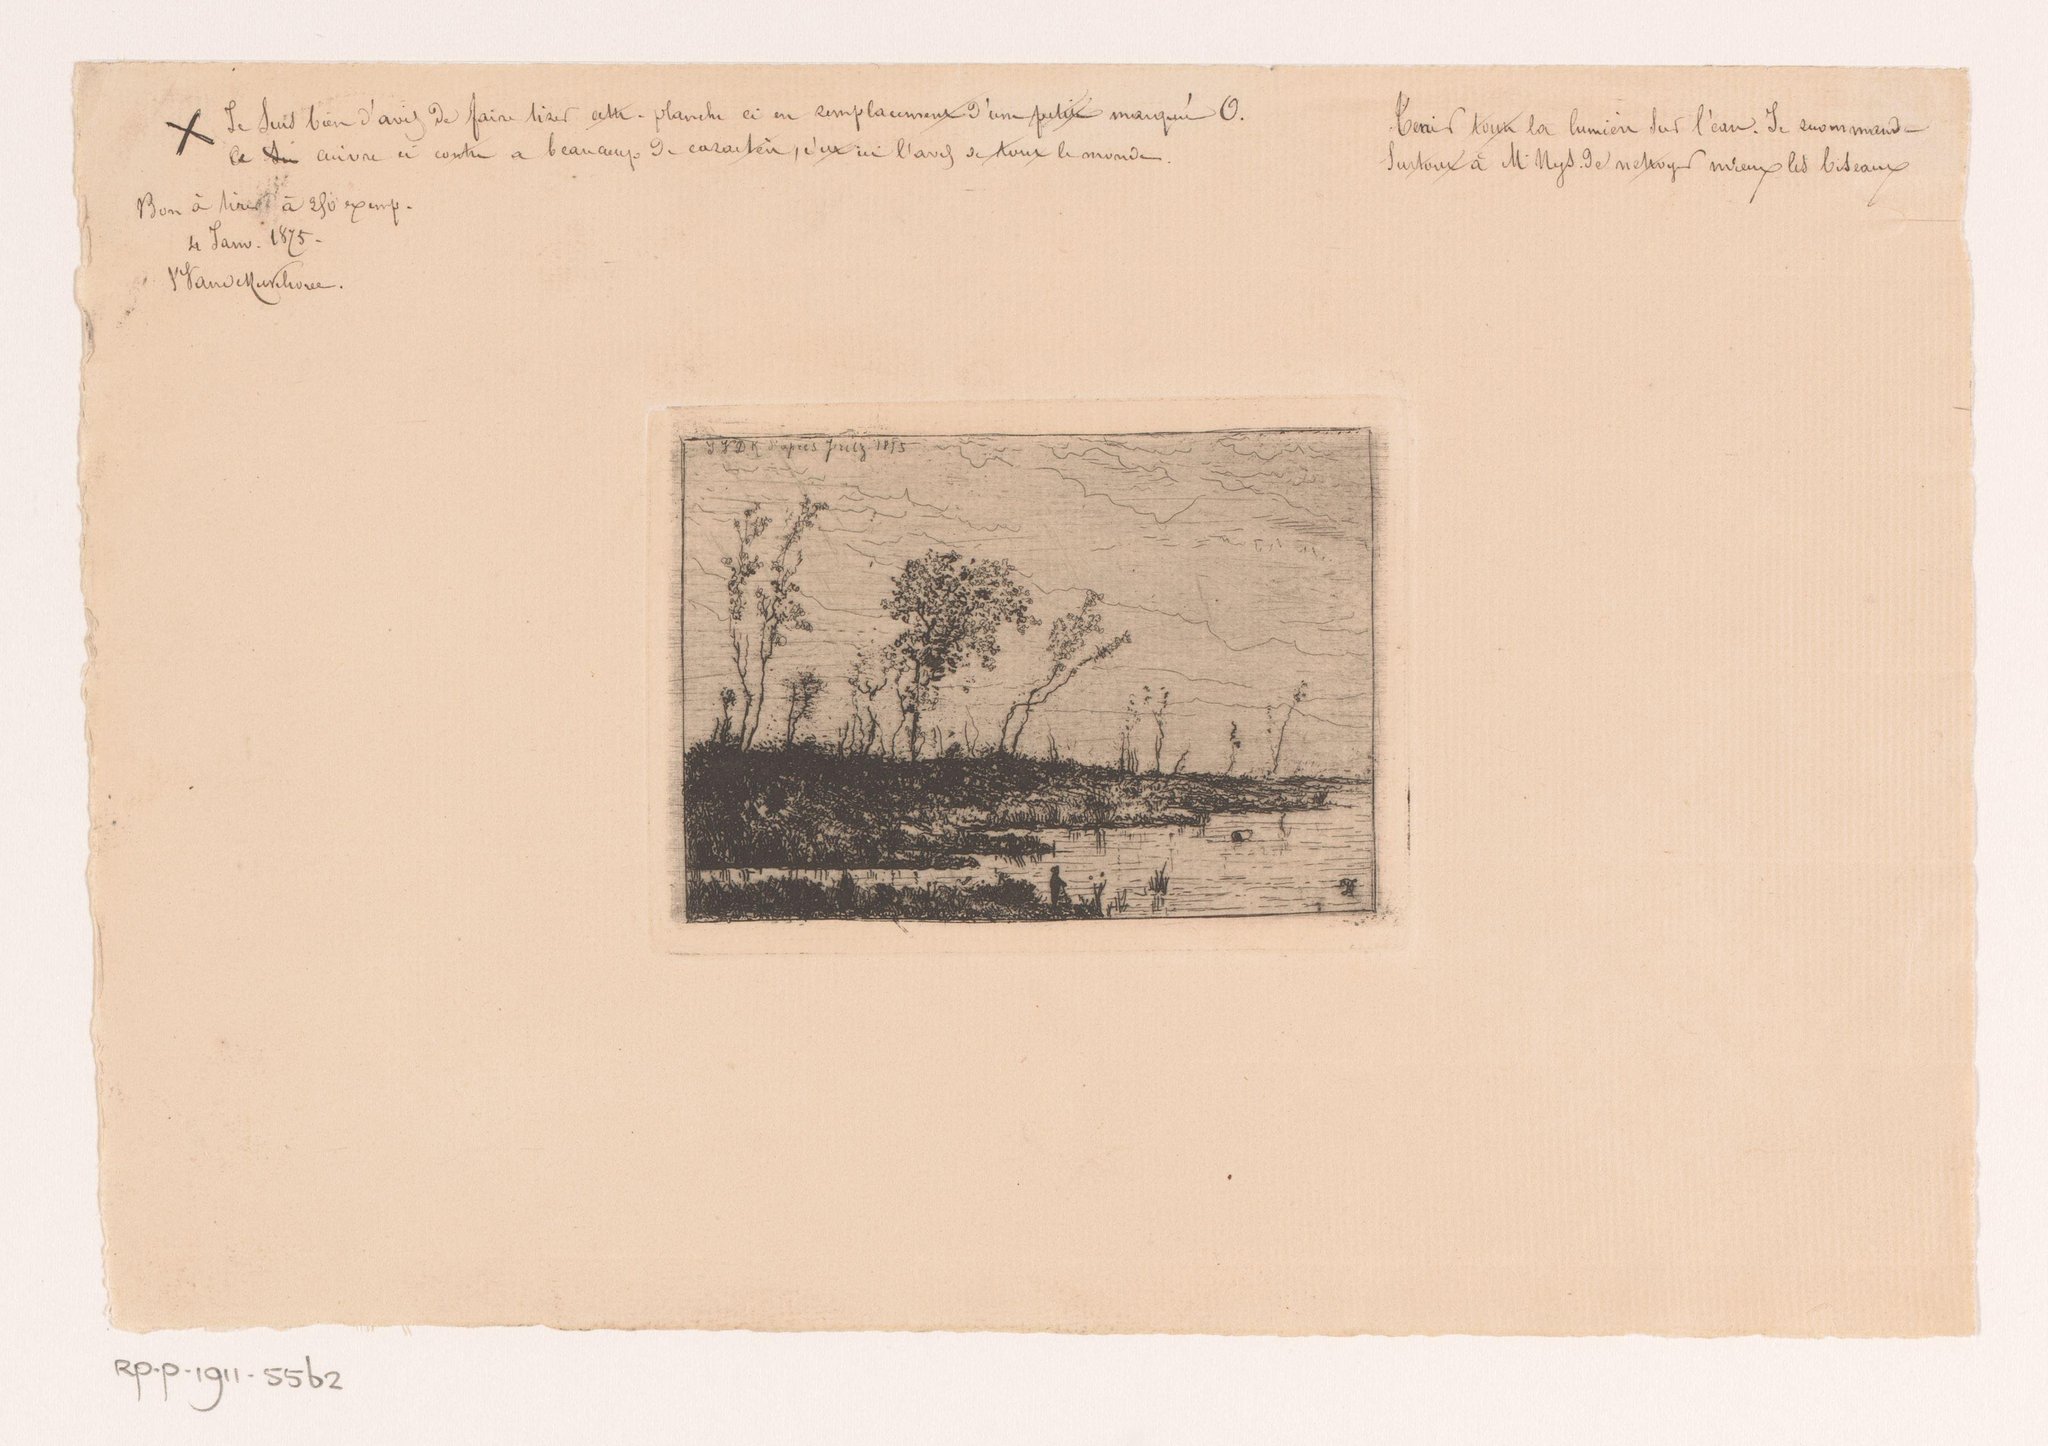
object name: print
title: Bomen op de oever van een meer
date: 1875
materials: paper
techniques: etching, intaglio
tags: lake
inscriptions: collector's mark: Lugt 2228, annotation: ‘Je suis bien d'avis de faire tirer cette planche ci en emplacement d'un petit manqué O. ce cuivre á contre a beaucoup de caractère [...] de tout le monde. Tenir tout la lumière sur l'eau. Je recommand surtout à Mr. Nys. Je [...] mieux les biseaux. Bon à tirer á 280 exemp. 4 Janv. 1875.’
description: De etsen naar de schilderijen van Frédéric Van de Kerkhove werden na zijn dood door zijn vader en zuster gemaakt en uitgegeven in twee reeksen. De eerste werd in 1877 uitgegeven door het Journal des Beaux-Arts et de la Littérature: Cahier de 25 Eaux-fortes d'après Frédéric van de Kerkhove, gravées par son père et sa sœur. De tweede reeks van 126 etsen, ook in 1877, werd in Parijs uitgegeven bij A. Lévy onder de titel Cent eaux-fortes gravées par J. Van de Kerkhove d'après les tableaux de Frédéric Van de Kerkhove, mort en 1873 à l'âge de 10 ans et 11 mois.